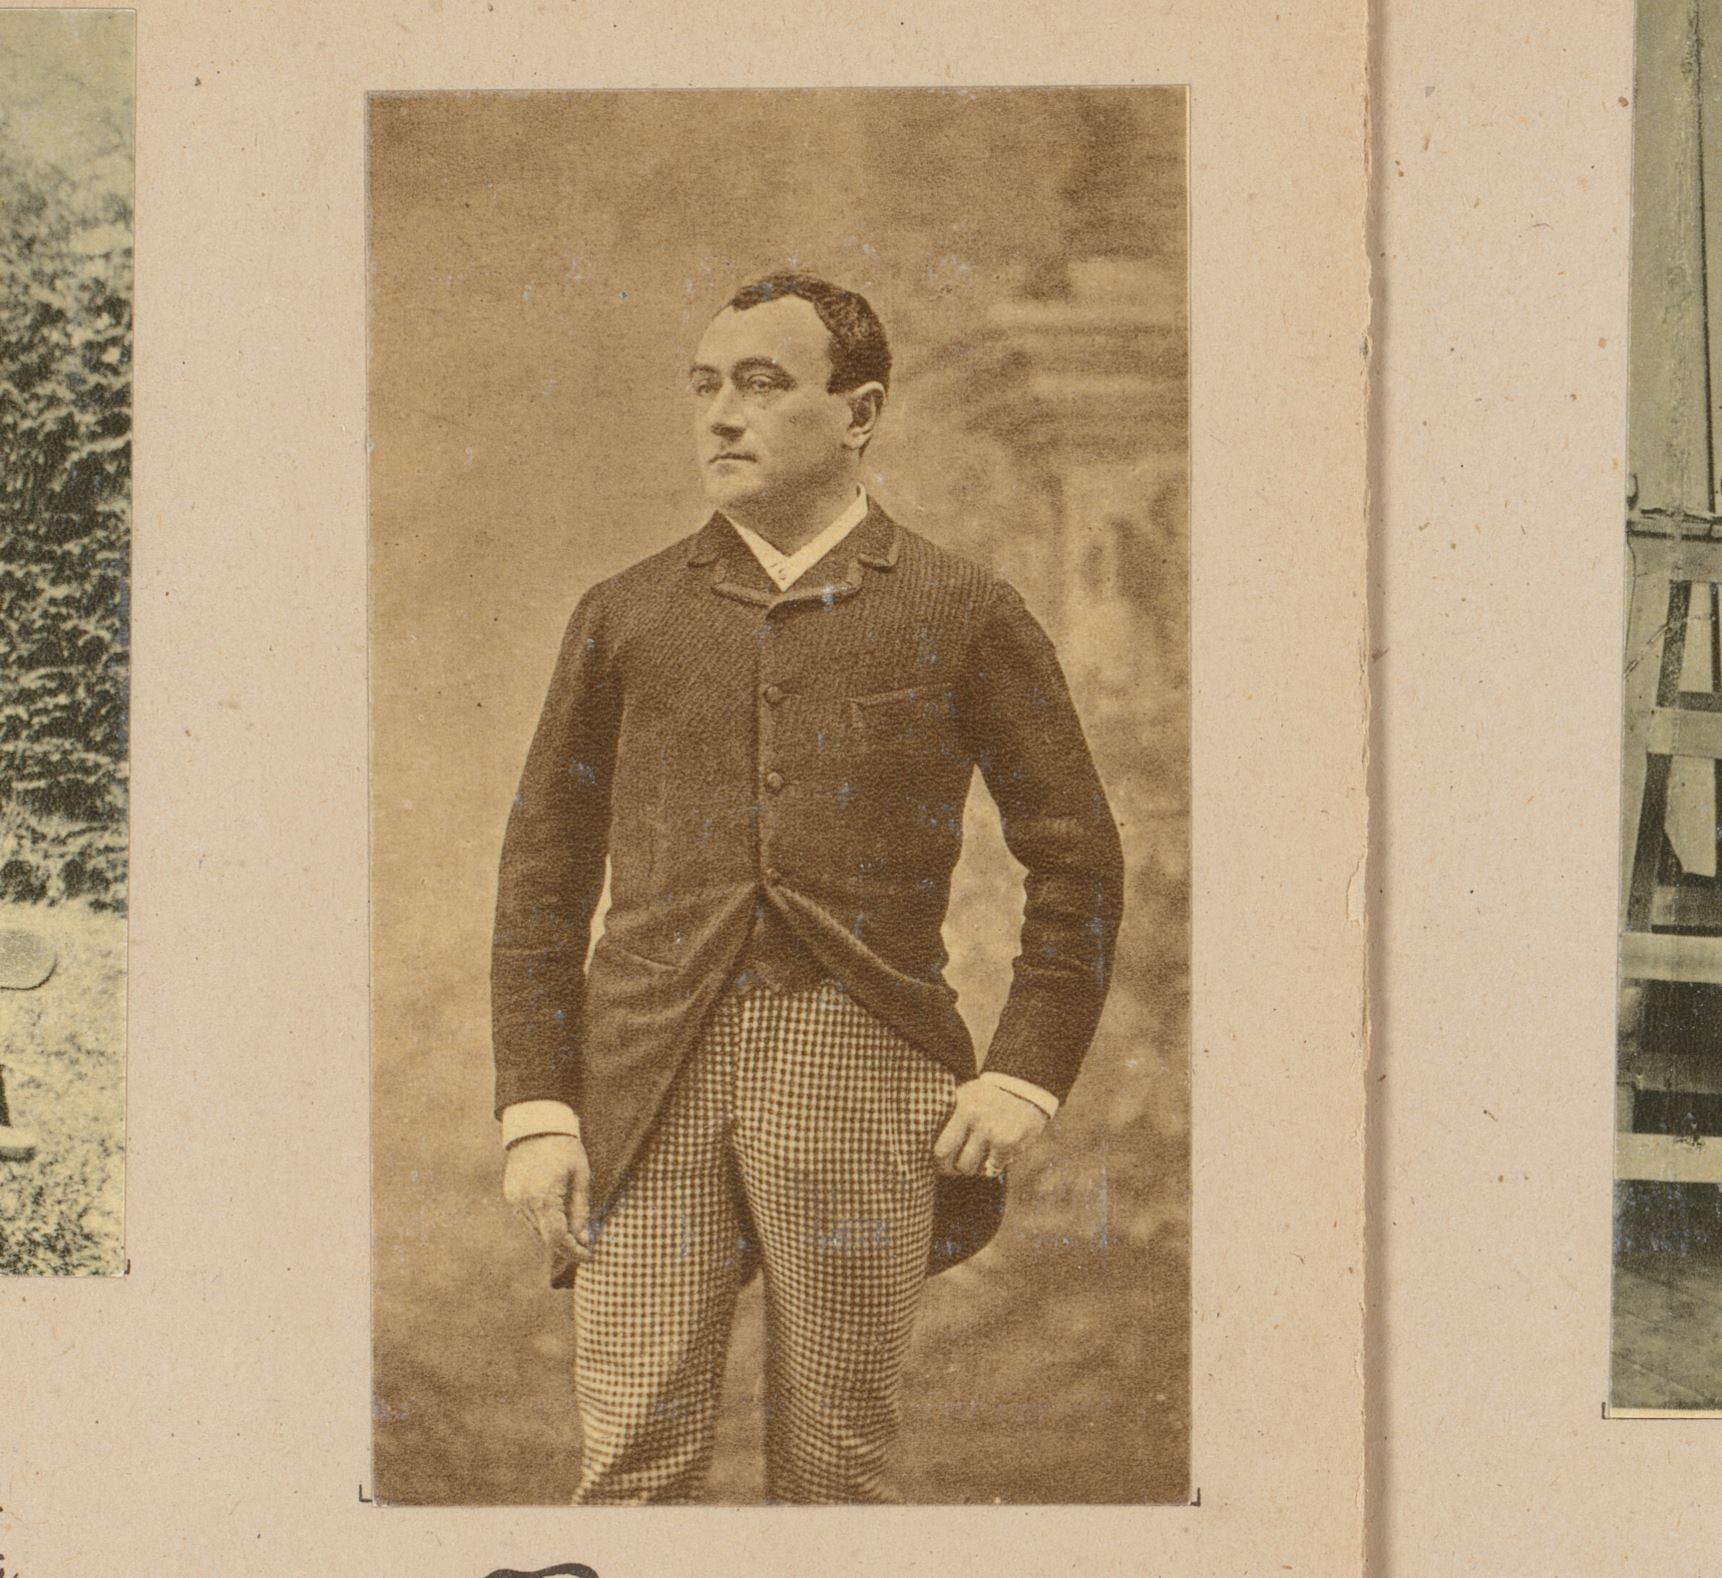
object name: album leaf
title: Portret van Jean-Paul Habans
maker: Anonymous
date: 1905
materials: paper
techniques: rotogravure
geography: france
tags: male singer, france